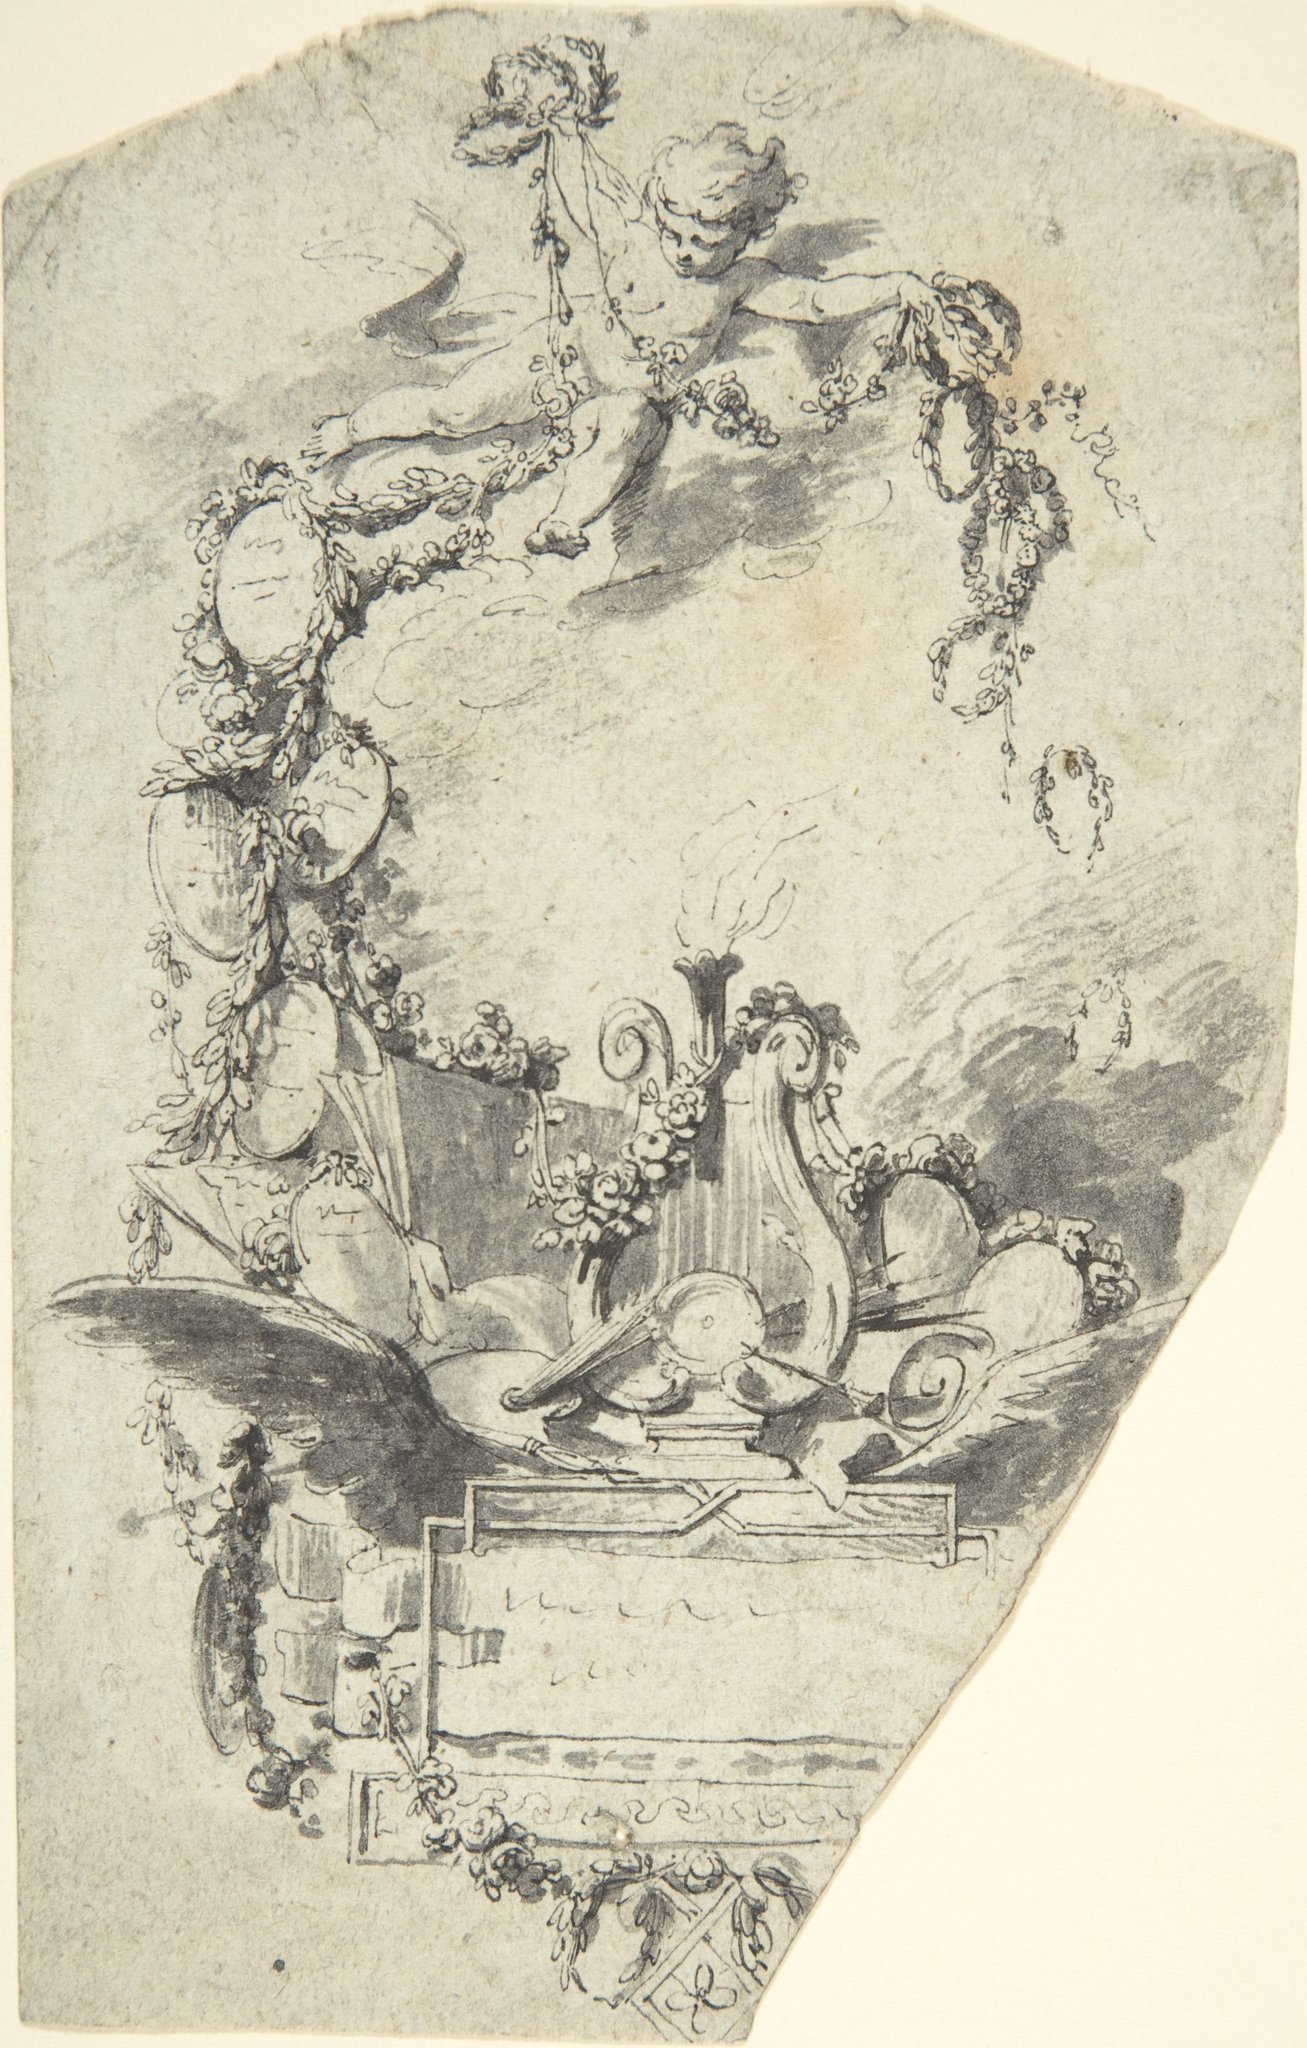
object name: drawing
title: Design for a Title Page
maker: anonymous, british, 18th century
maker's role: artist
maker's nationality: british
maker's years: 1700-1800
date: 1780-1800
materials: ink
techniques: brush, pen, wash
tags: garlands,harps,flowers